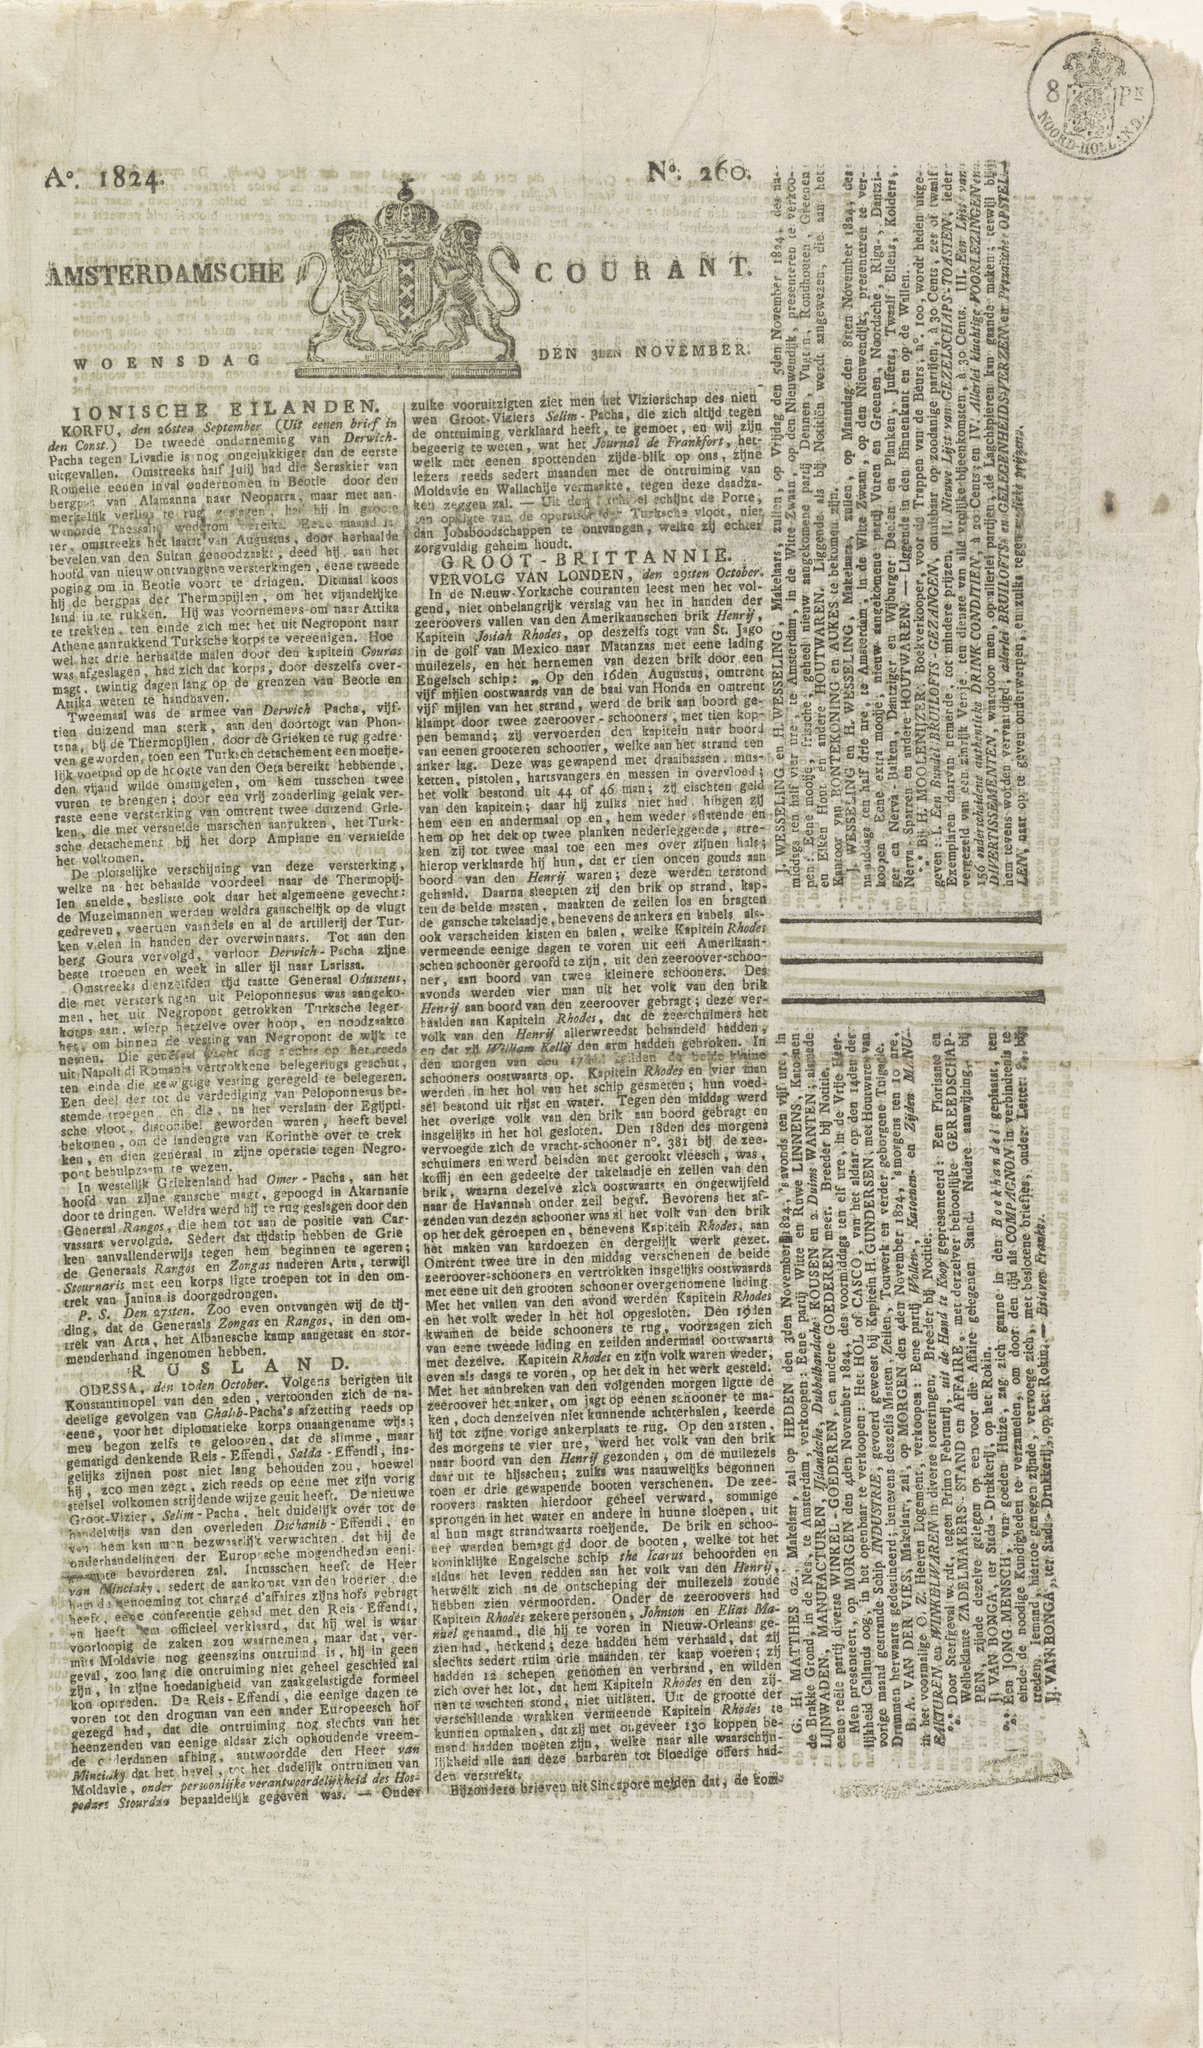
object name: text sheet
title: Amsterdamsche Courant van 3 november 1824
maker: jacobus van bonga jr.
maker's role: printer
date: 1824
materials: paper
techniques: letterpress printing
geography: amsterdam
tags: berlin, frederik (prins der nederlanden)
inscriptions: collector's mark: Lugt 2228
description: Exemplaar van de Amsterdamsche Courant van 3 november 1824 met binnenin een bericht over het voorgenomen huwelijk van prins Frederik en prinses Louise van Pruisen. Dubbelgevouwen blad bedrukt op alle vier zijden.